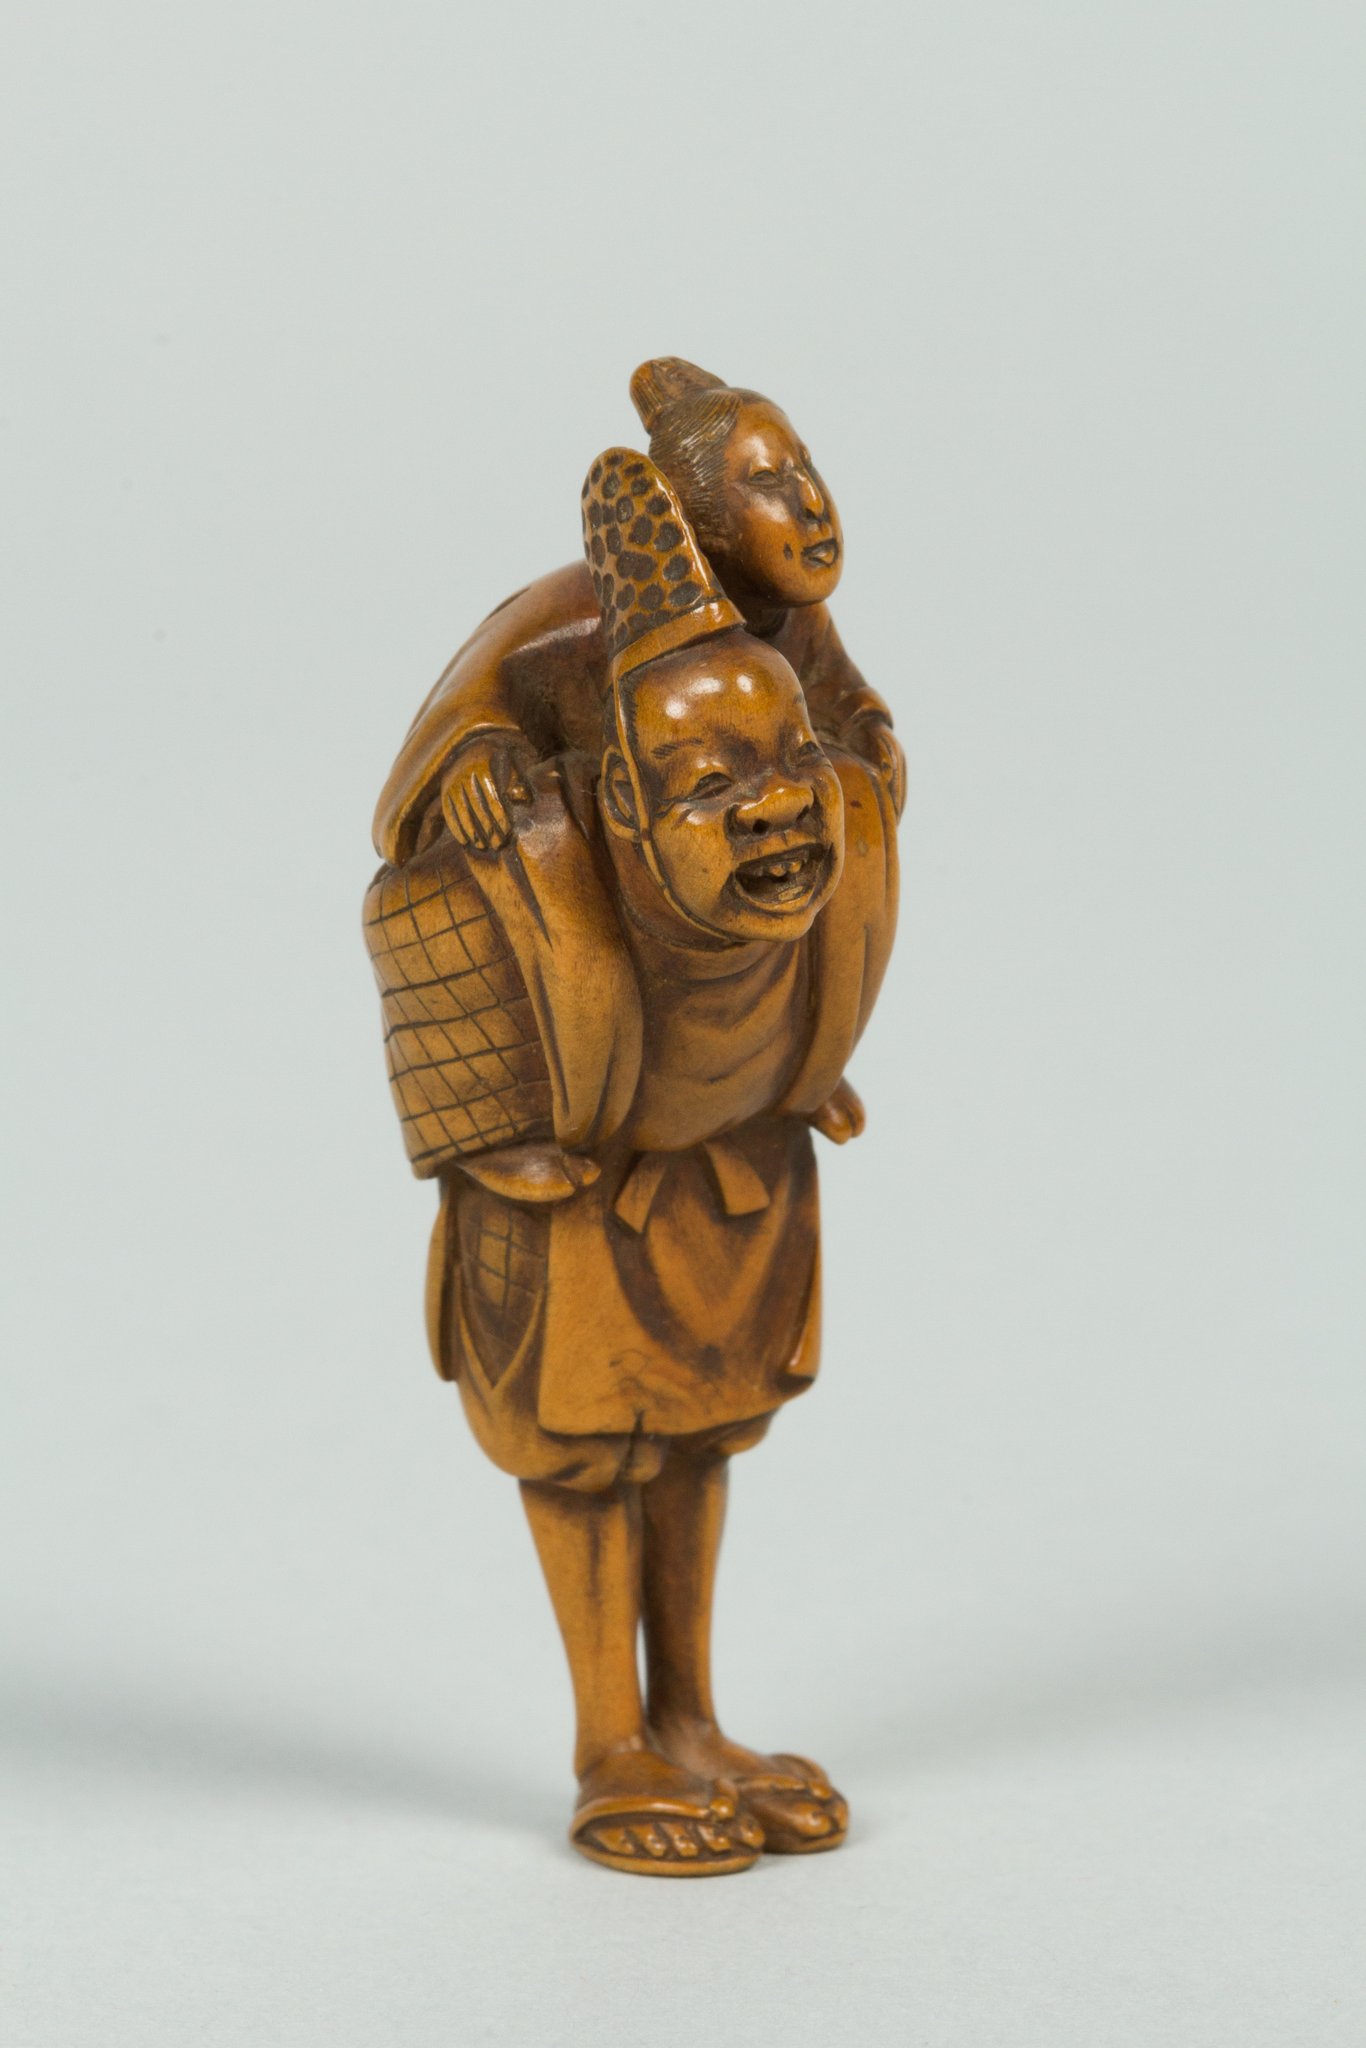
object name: netsuke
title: Netsuke of Man with Boy on His Back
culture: japanese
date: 1801-1900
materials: wood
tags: boys,men